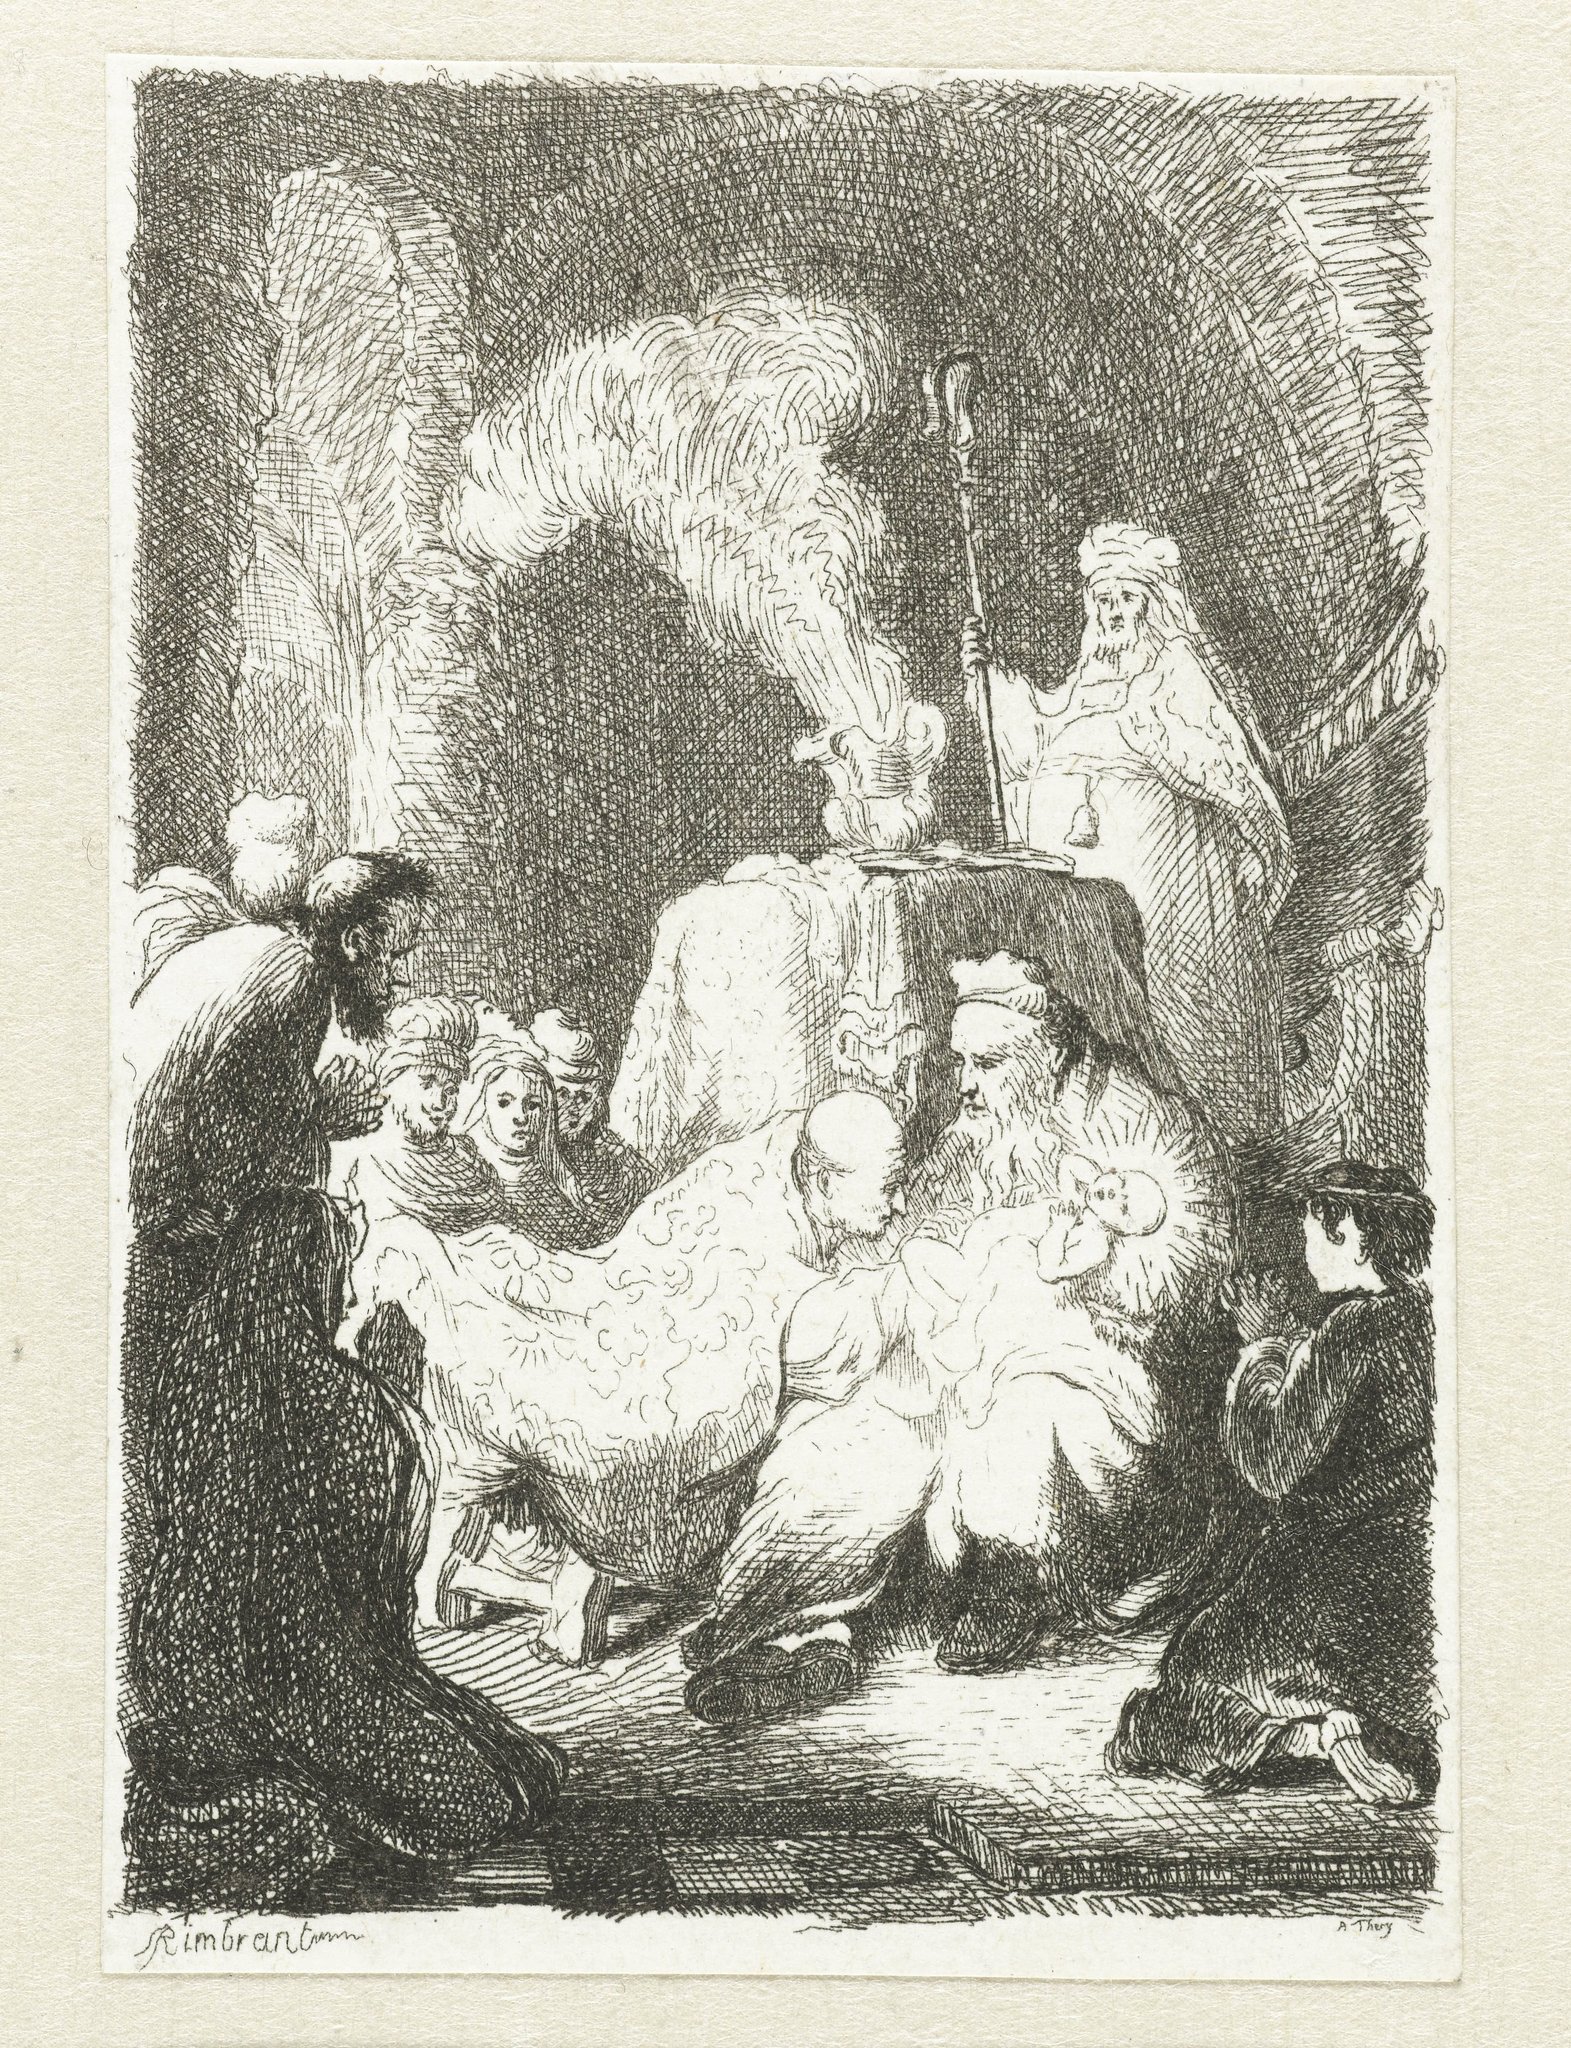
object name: print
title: The circumcision: small plate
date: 1640-1694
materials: paper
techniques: etching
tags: story of noah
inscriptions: collector's mark: Lugt 2228, collector's mark: Lugt 2760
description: Spiegelbeeldige kopie naar de gelijknamige prent van Rembrandt.